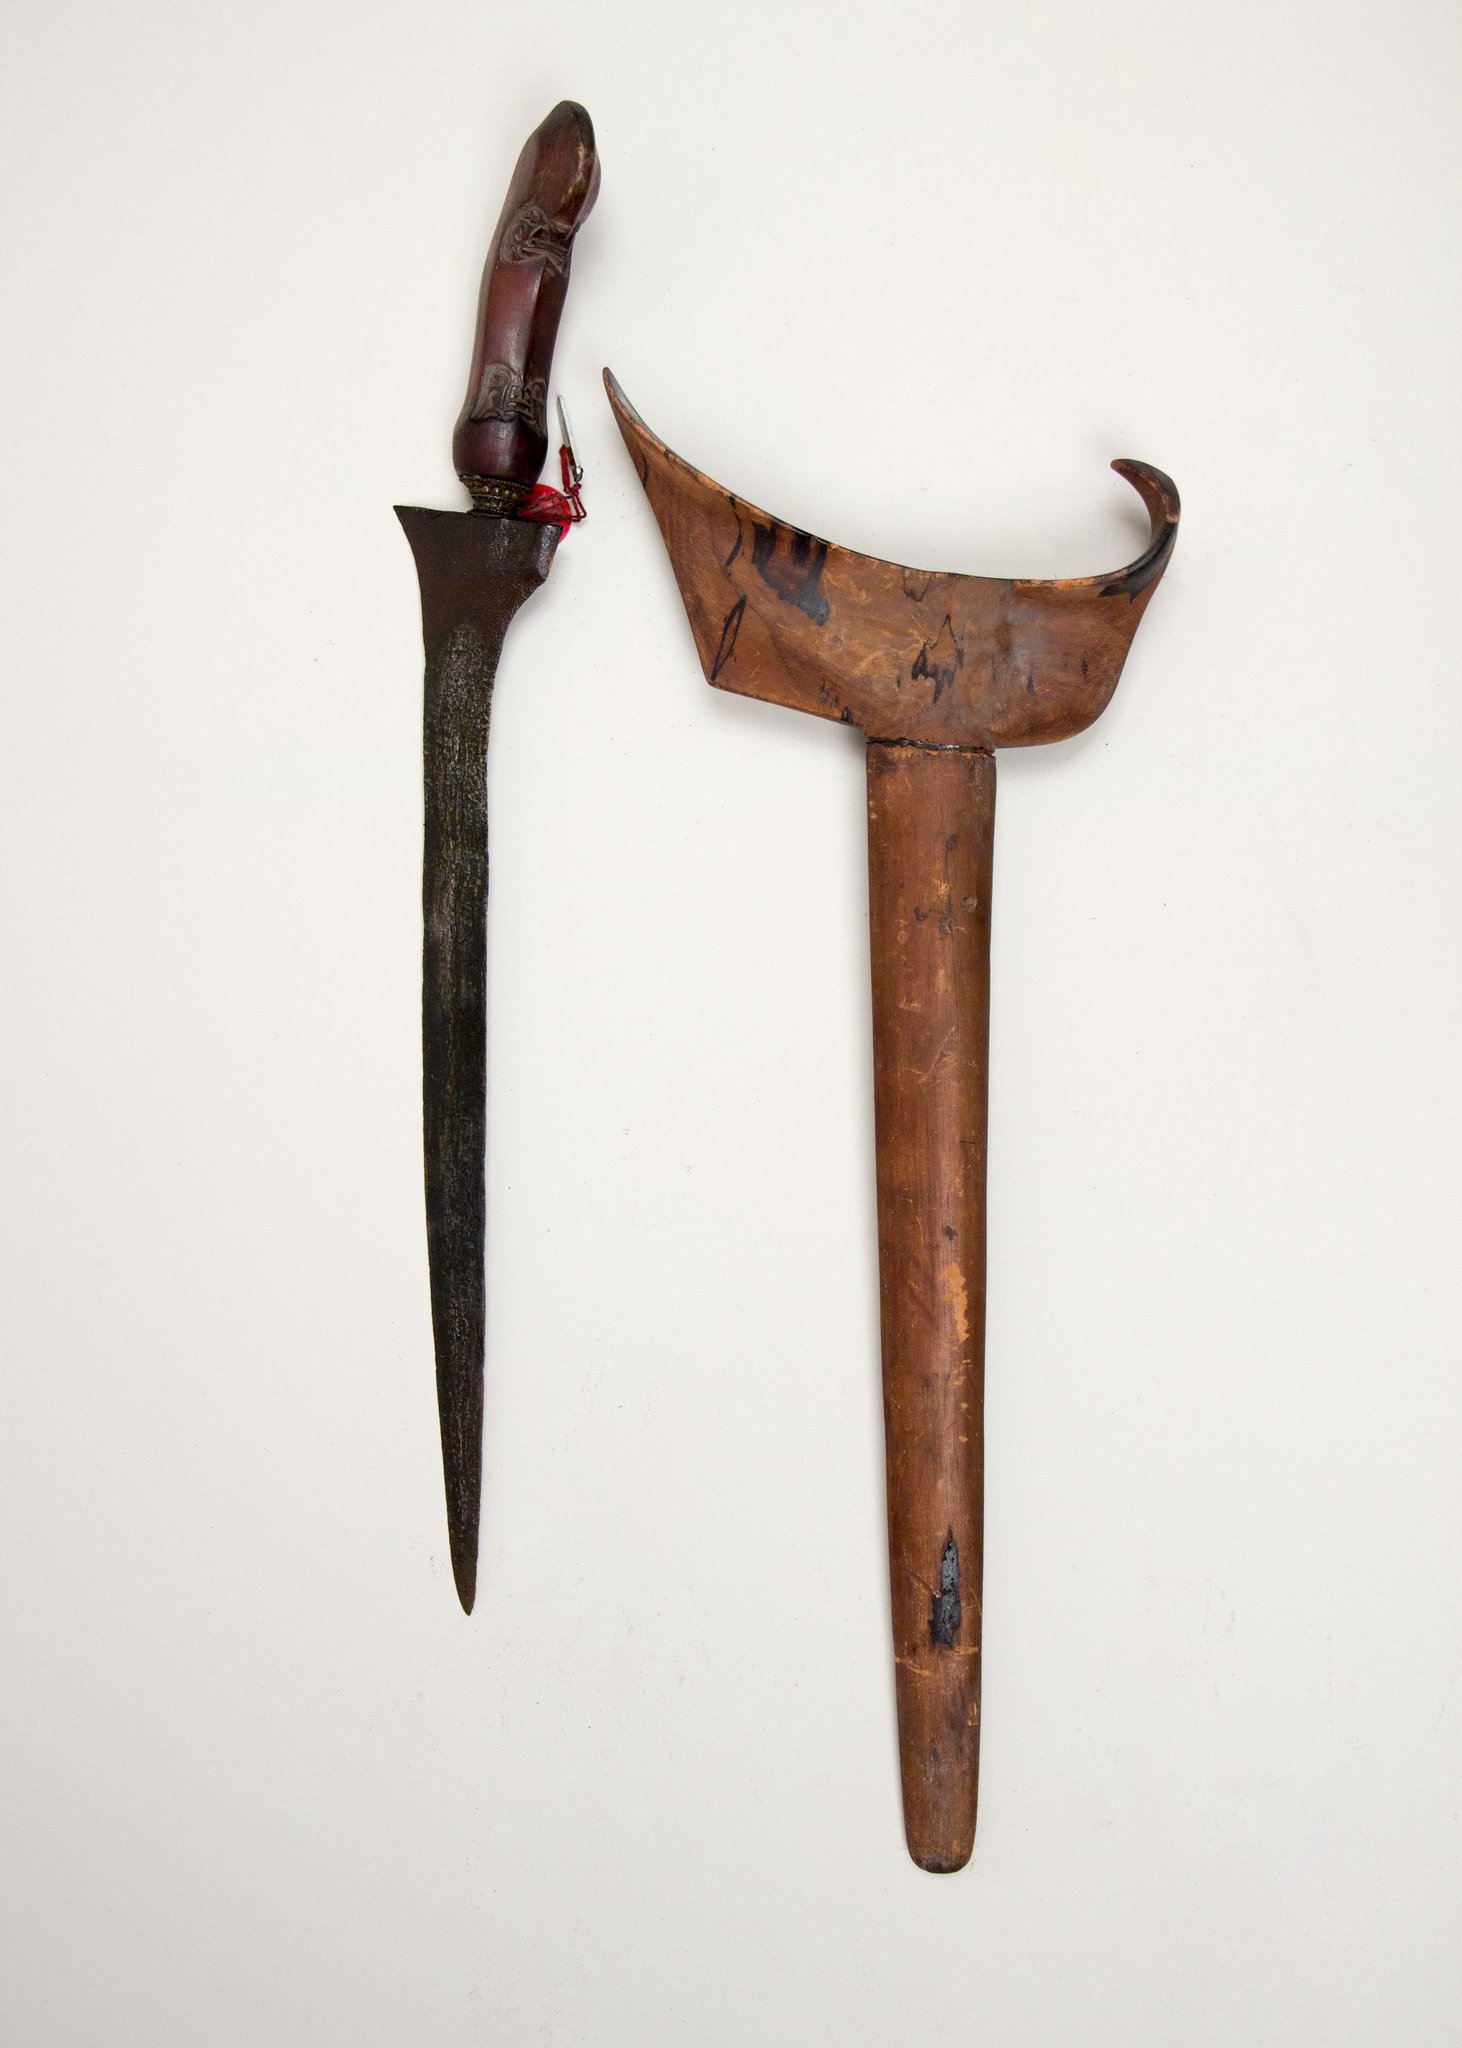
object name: kris with sheath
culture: javanese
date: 1501-1900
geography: indonesia